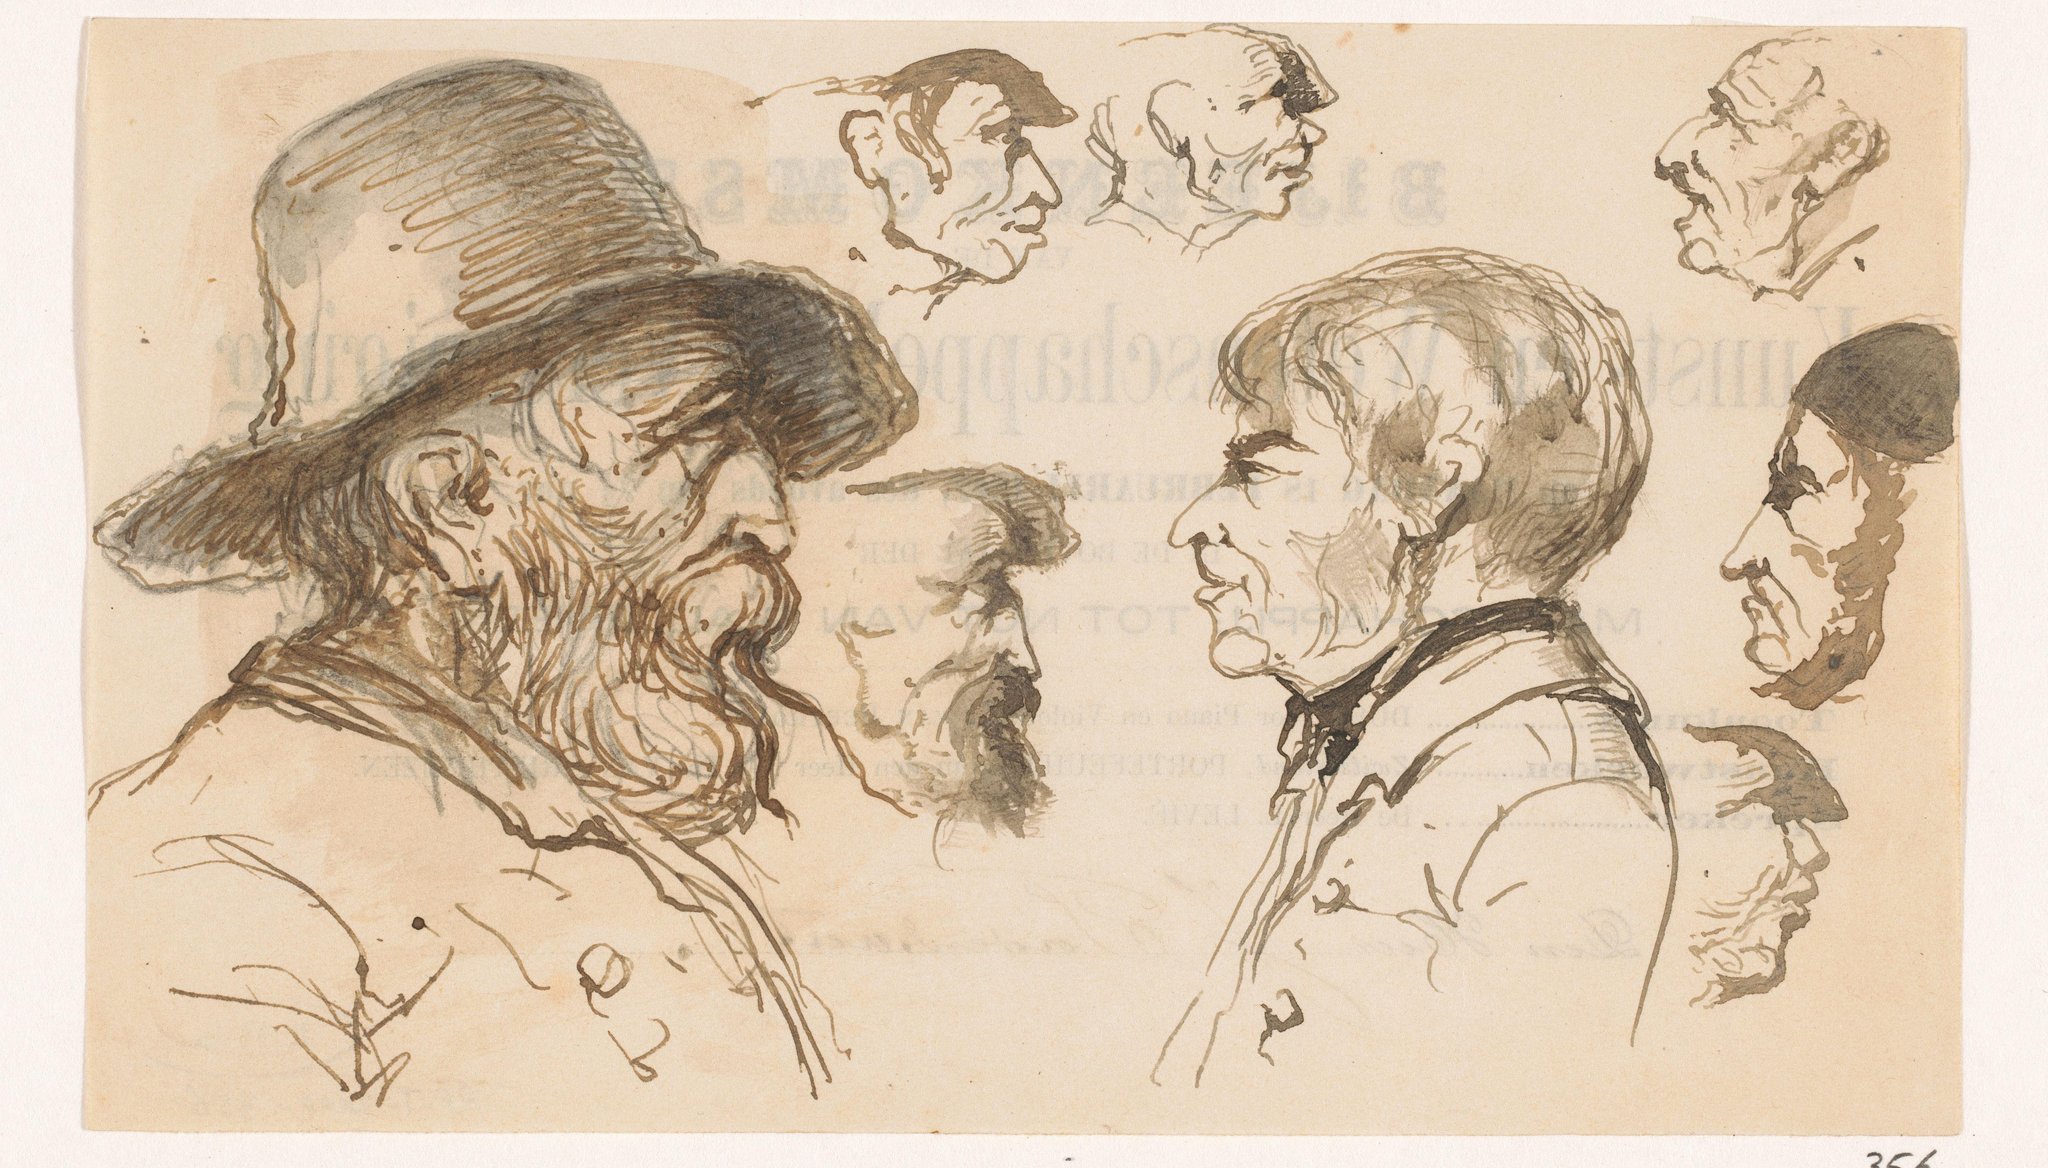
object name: drawing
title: Studieblad met koppen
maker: johannes tavenraat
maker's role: draughtsman, painter, print maker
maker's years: 1809-1881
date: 1867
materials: ink, paper, pencil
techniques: pen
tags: caricatures (human types)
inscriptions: collector's mark: Lugt 2228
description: Studieblad met koppen. Getekend op de achterzijde van een gedrukte uitnodiging voor een bijeenkomst van de 'Kunst- en Wetenschappelijke Vereeniging' op 18 februari 1867.